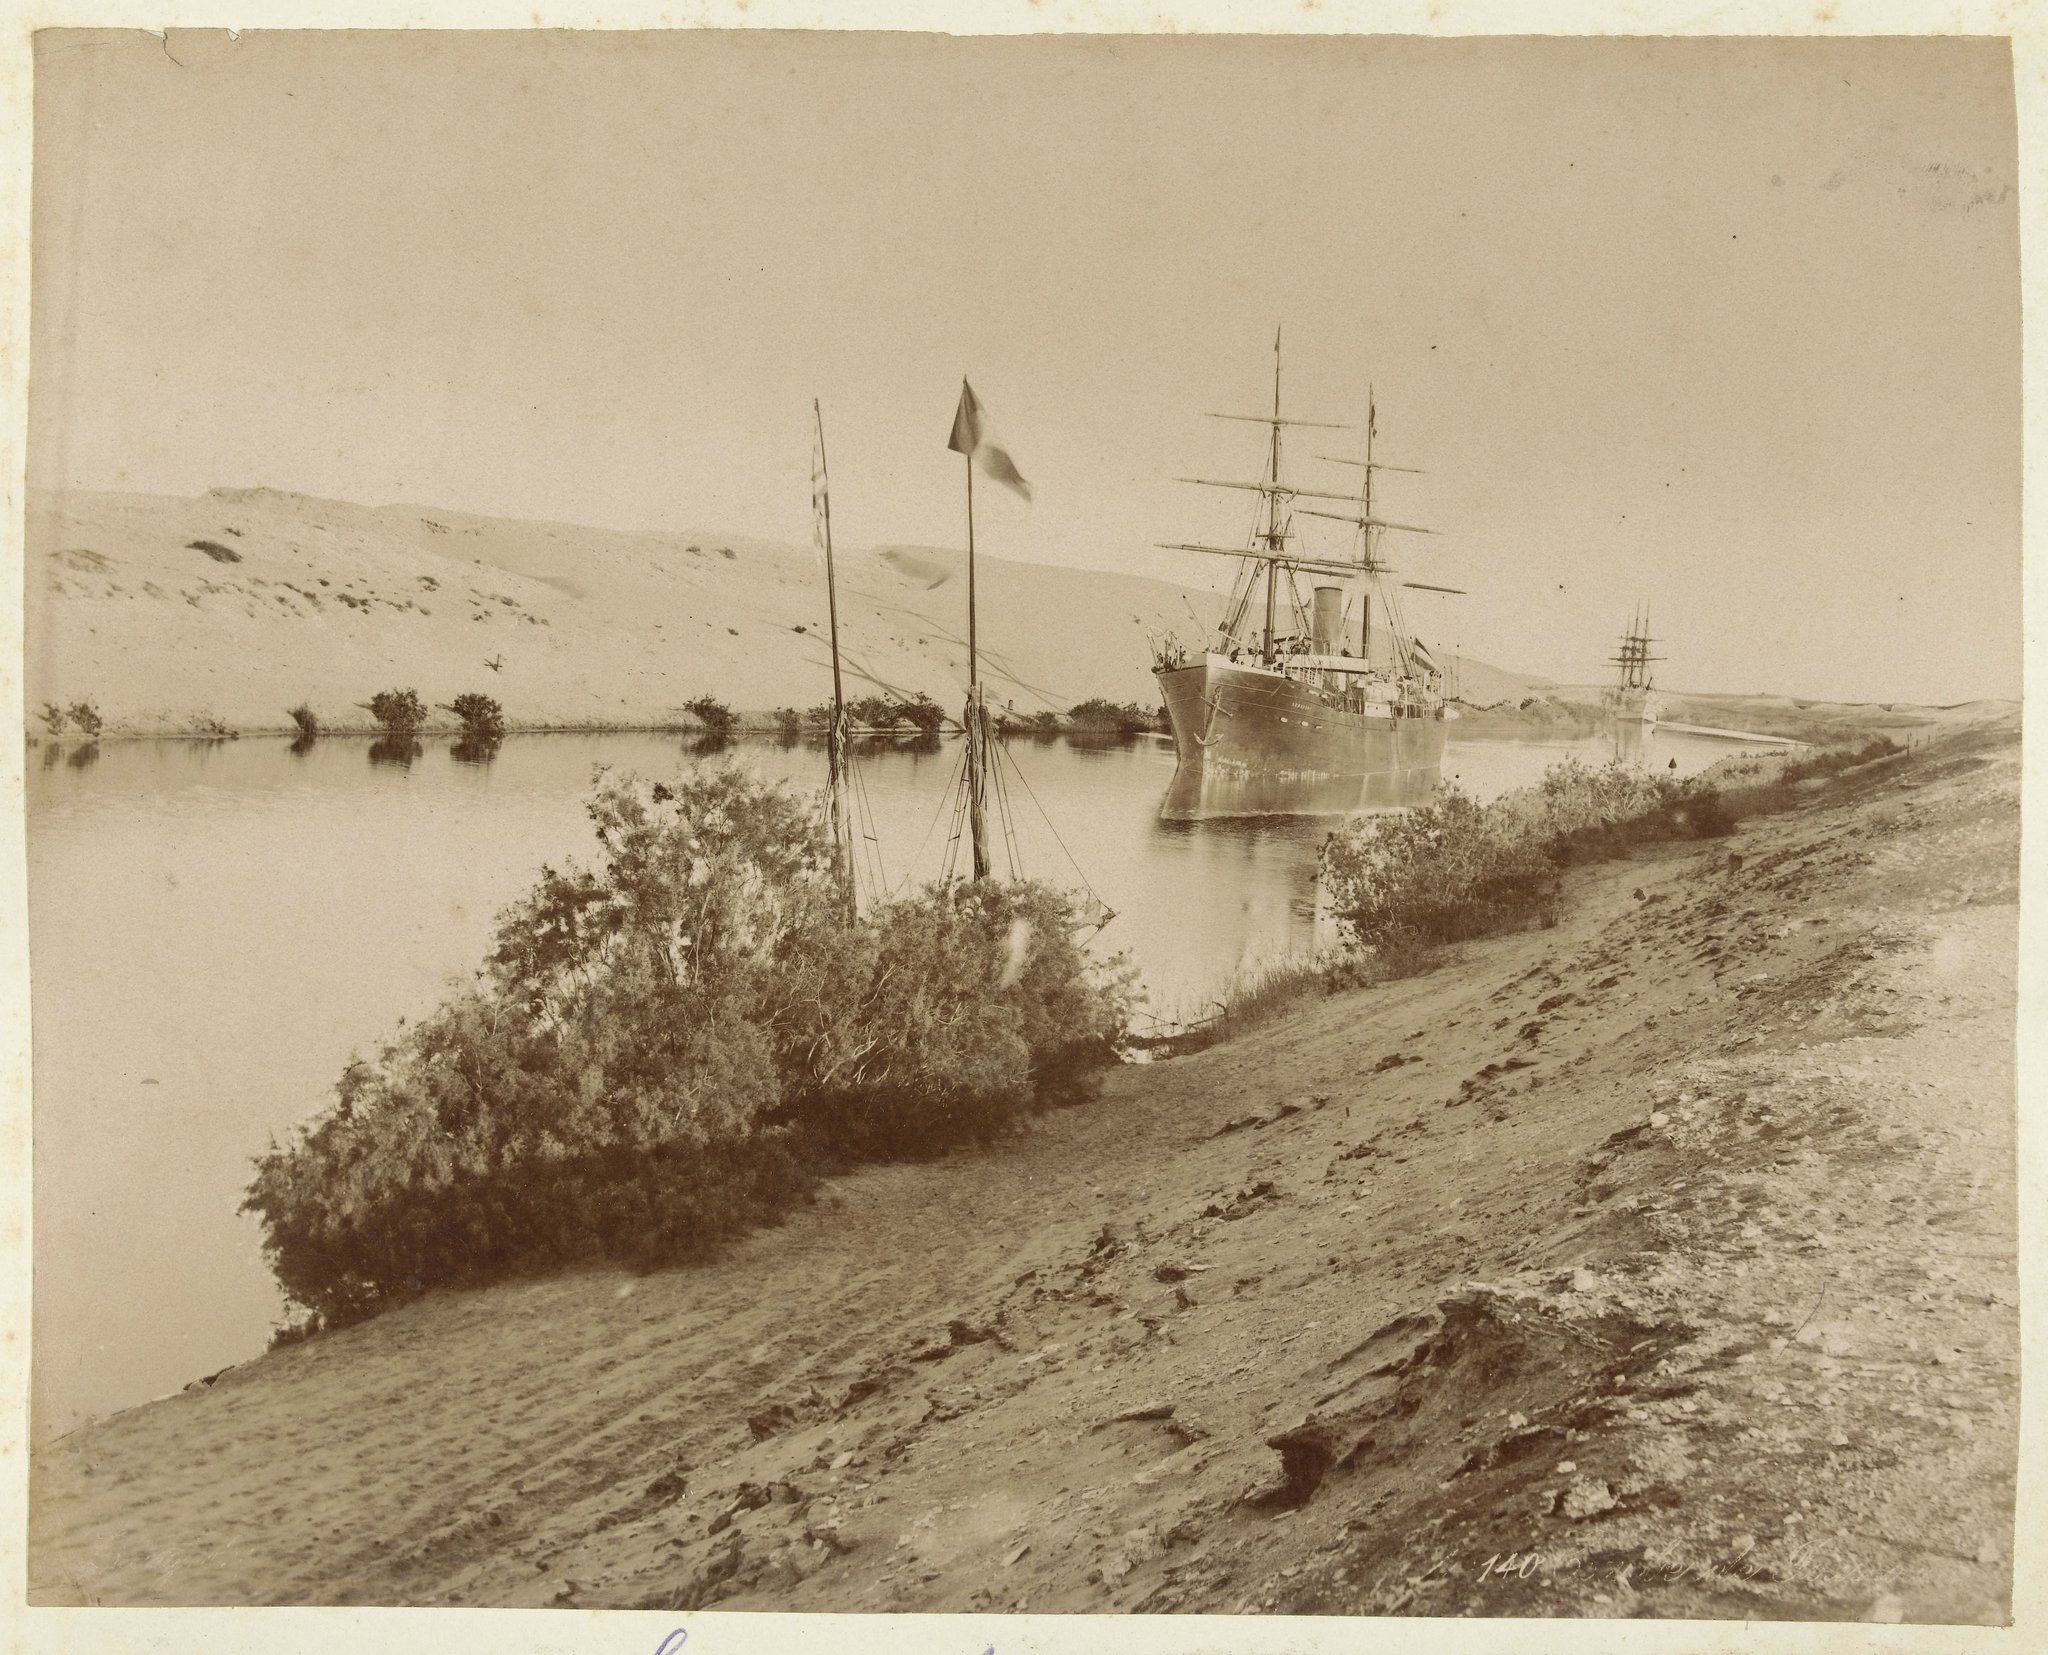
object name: photograph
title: Suez kanaal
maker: Anonymous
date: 1890-1910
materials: cardboard, paper, photographic support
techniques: gelatin silver print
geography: egypt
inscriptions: caption: ‘Suez kanaal’